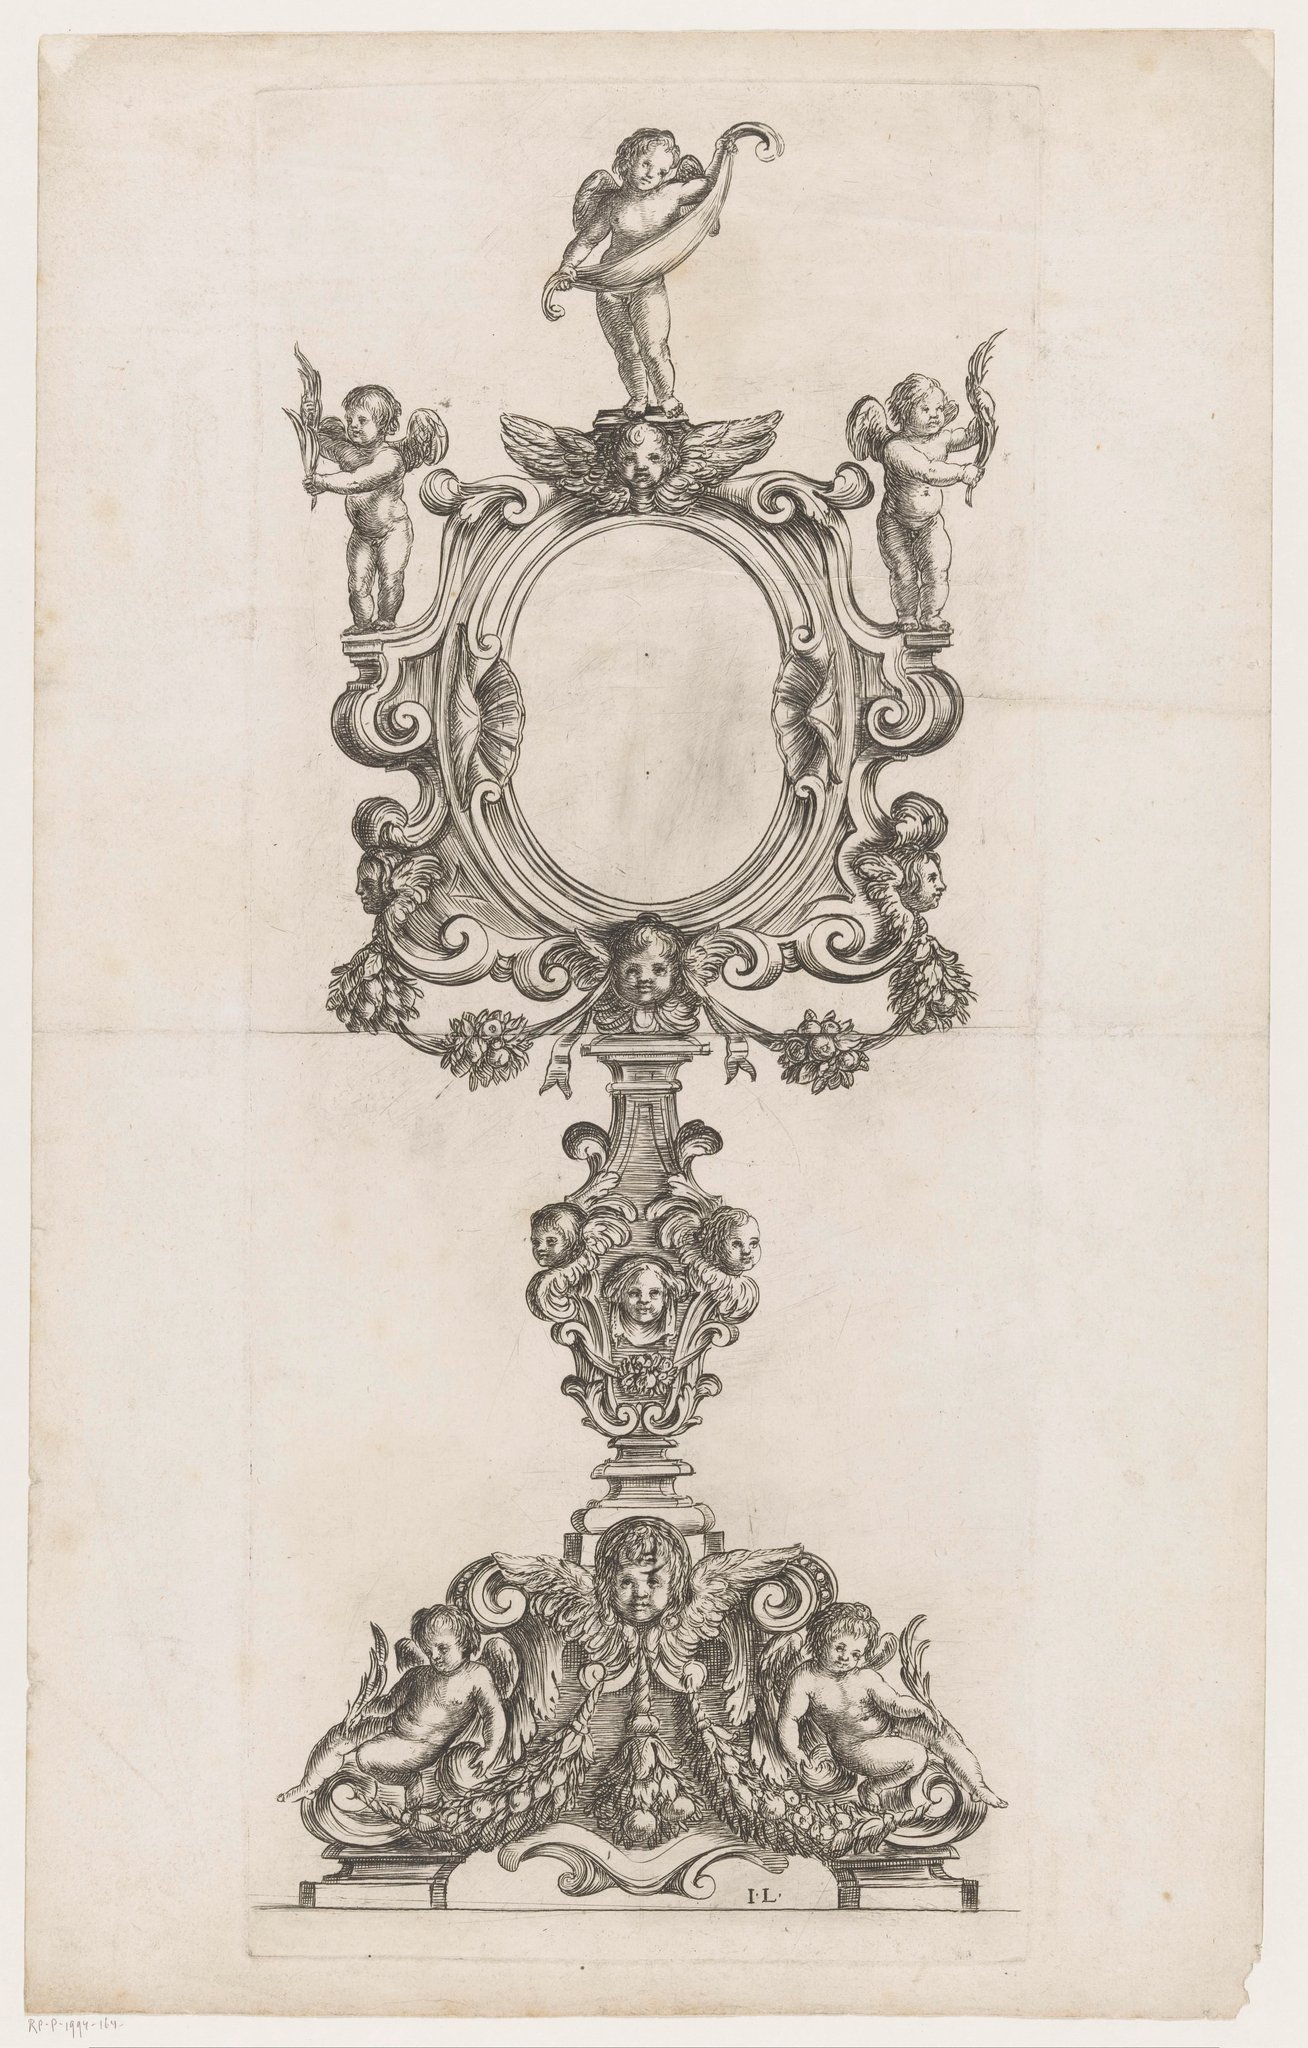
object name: print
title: Opere per Argentiri et altri di Iacomo Laurentiani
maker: giacomo laurenziani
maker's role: print maker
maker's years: 1600-1650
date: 1637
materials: paper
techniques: etching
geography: italy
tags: ostensorium, monstrance, cupids: 'amores', 'amoretti', 'putti'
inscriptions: collector's mark: Lugt 2760, collector's mark: Lugt 2228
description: Een monstrans met ovaal bovenstuk, gedecoreerd met drie putti en vier cherubijnen. Op de knoop van de stam drie cherubijnen. Het voetstuk is gedecoreerd met twee zittende putti, een cherubijn en guirlandes.